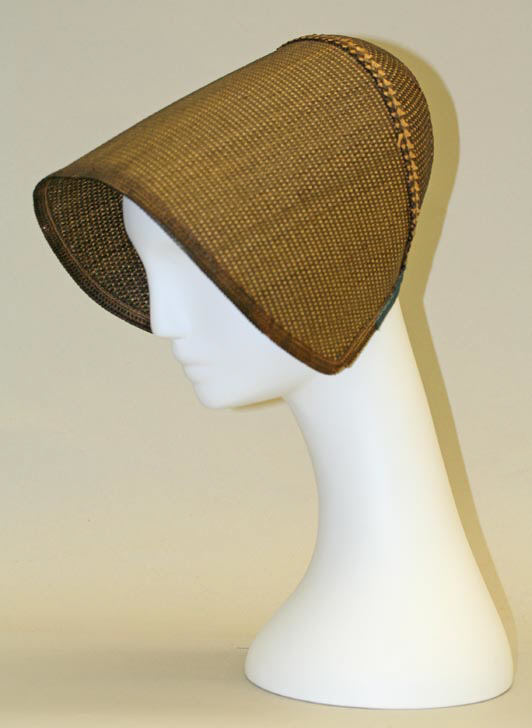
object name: bonnet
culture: american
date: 1840-1849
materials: fiber